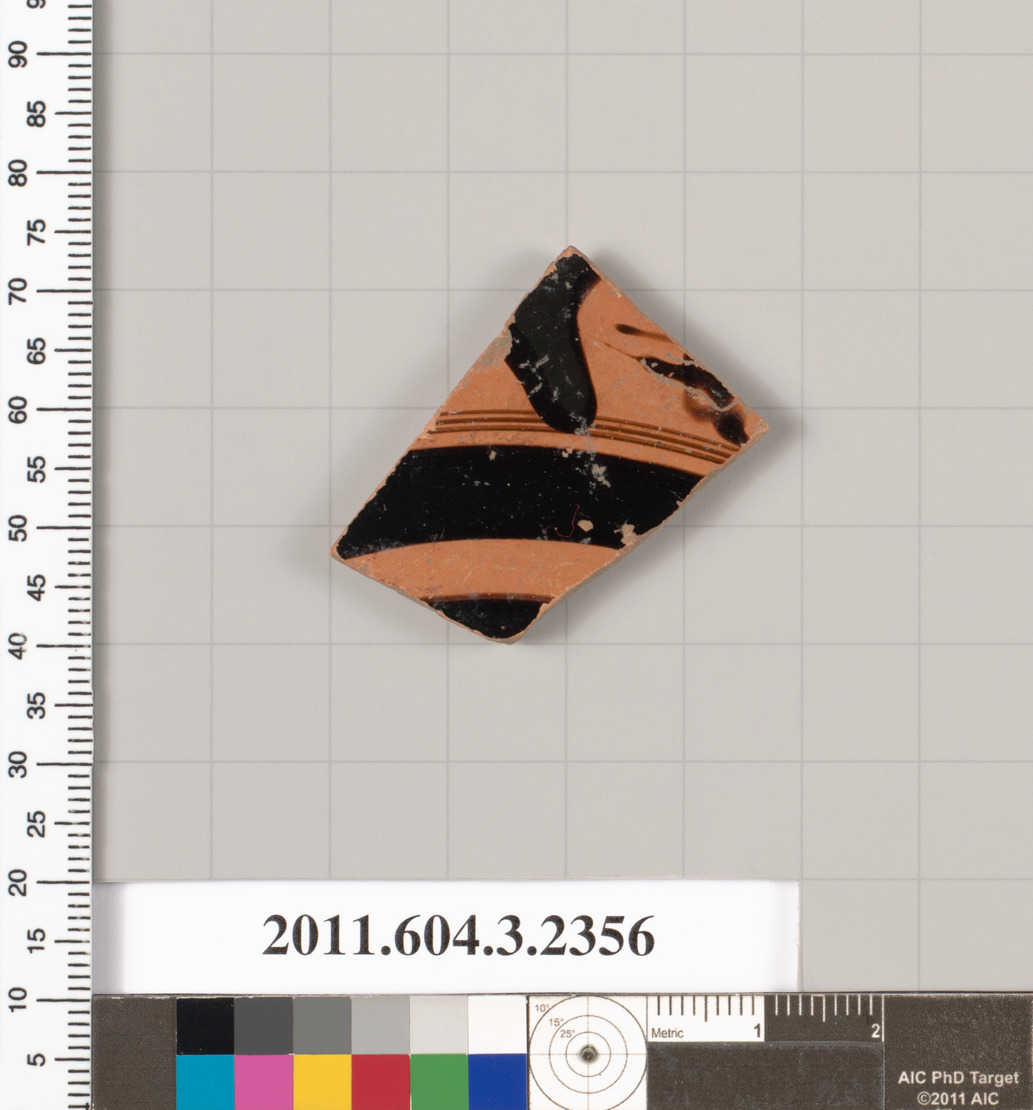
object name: kylix fragment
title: Terracotta fragment of a kylix: eye-cup (drinking cup)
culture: greek, attic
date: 530-510 BCE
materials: terracotta